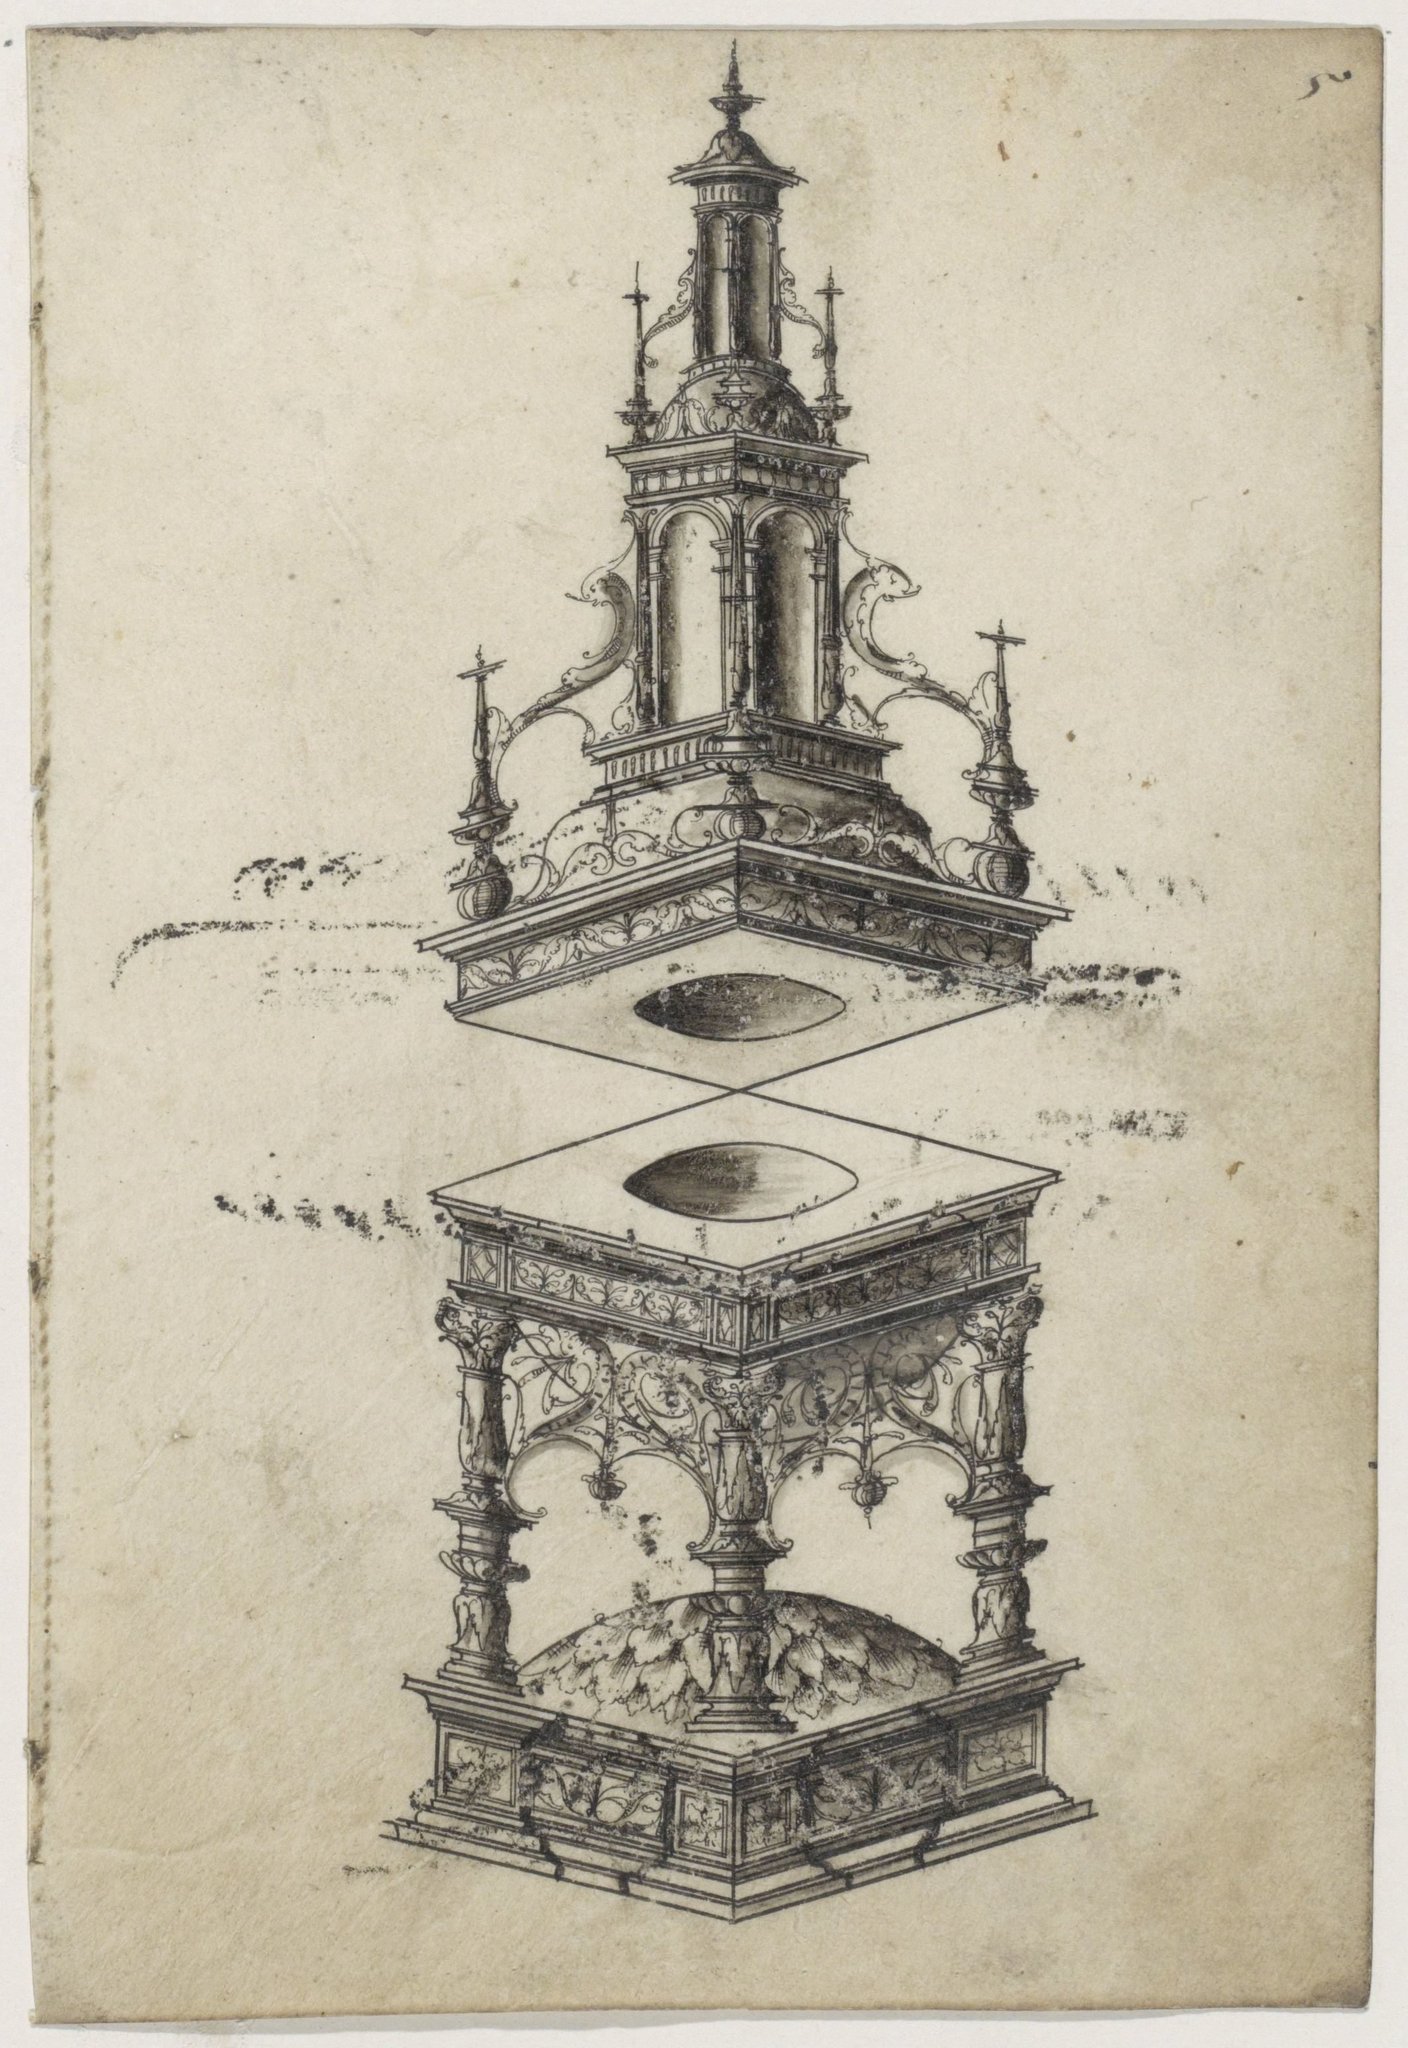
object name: album leaf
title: Zoutvat of doopvont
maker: jacques androuet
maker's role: draughtsman, print maker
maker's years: 1515-1584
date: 1543-1553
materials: ink, parchment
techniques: brush, pen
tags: baptismal font, salt-cellar, salt-shaker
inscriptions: number: ‘5’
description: Blad 5 recto, los opgezet blad uit een album bestaande uit een band met twee bladen, een schutblad en zeventien apart opgezette bladen.